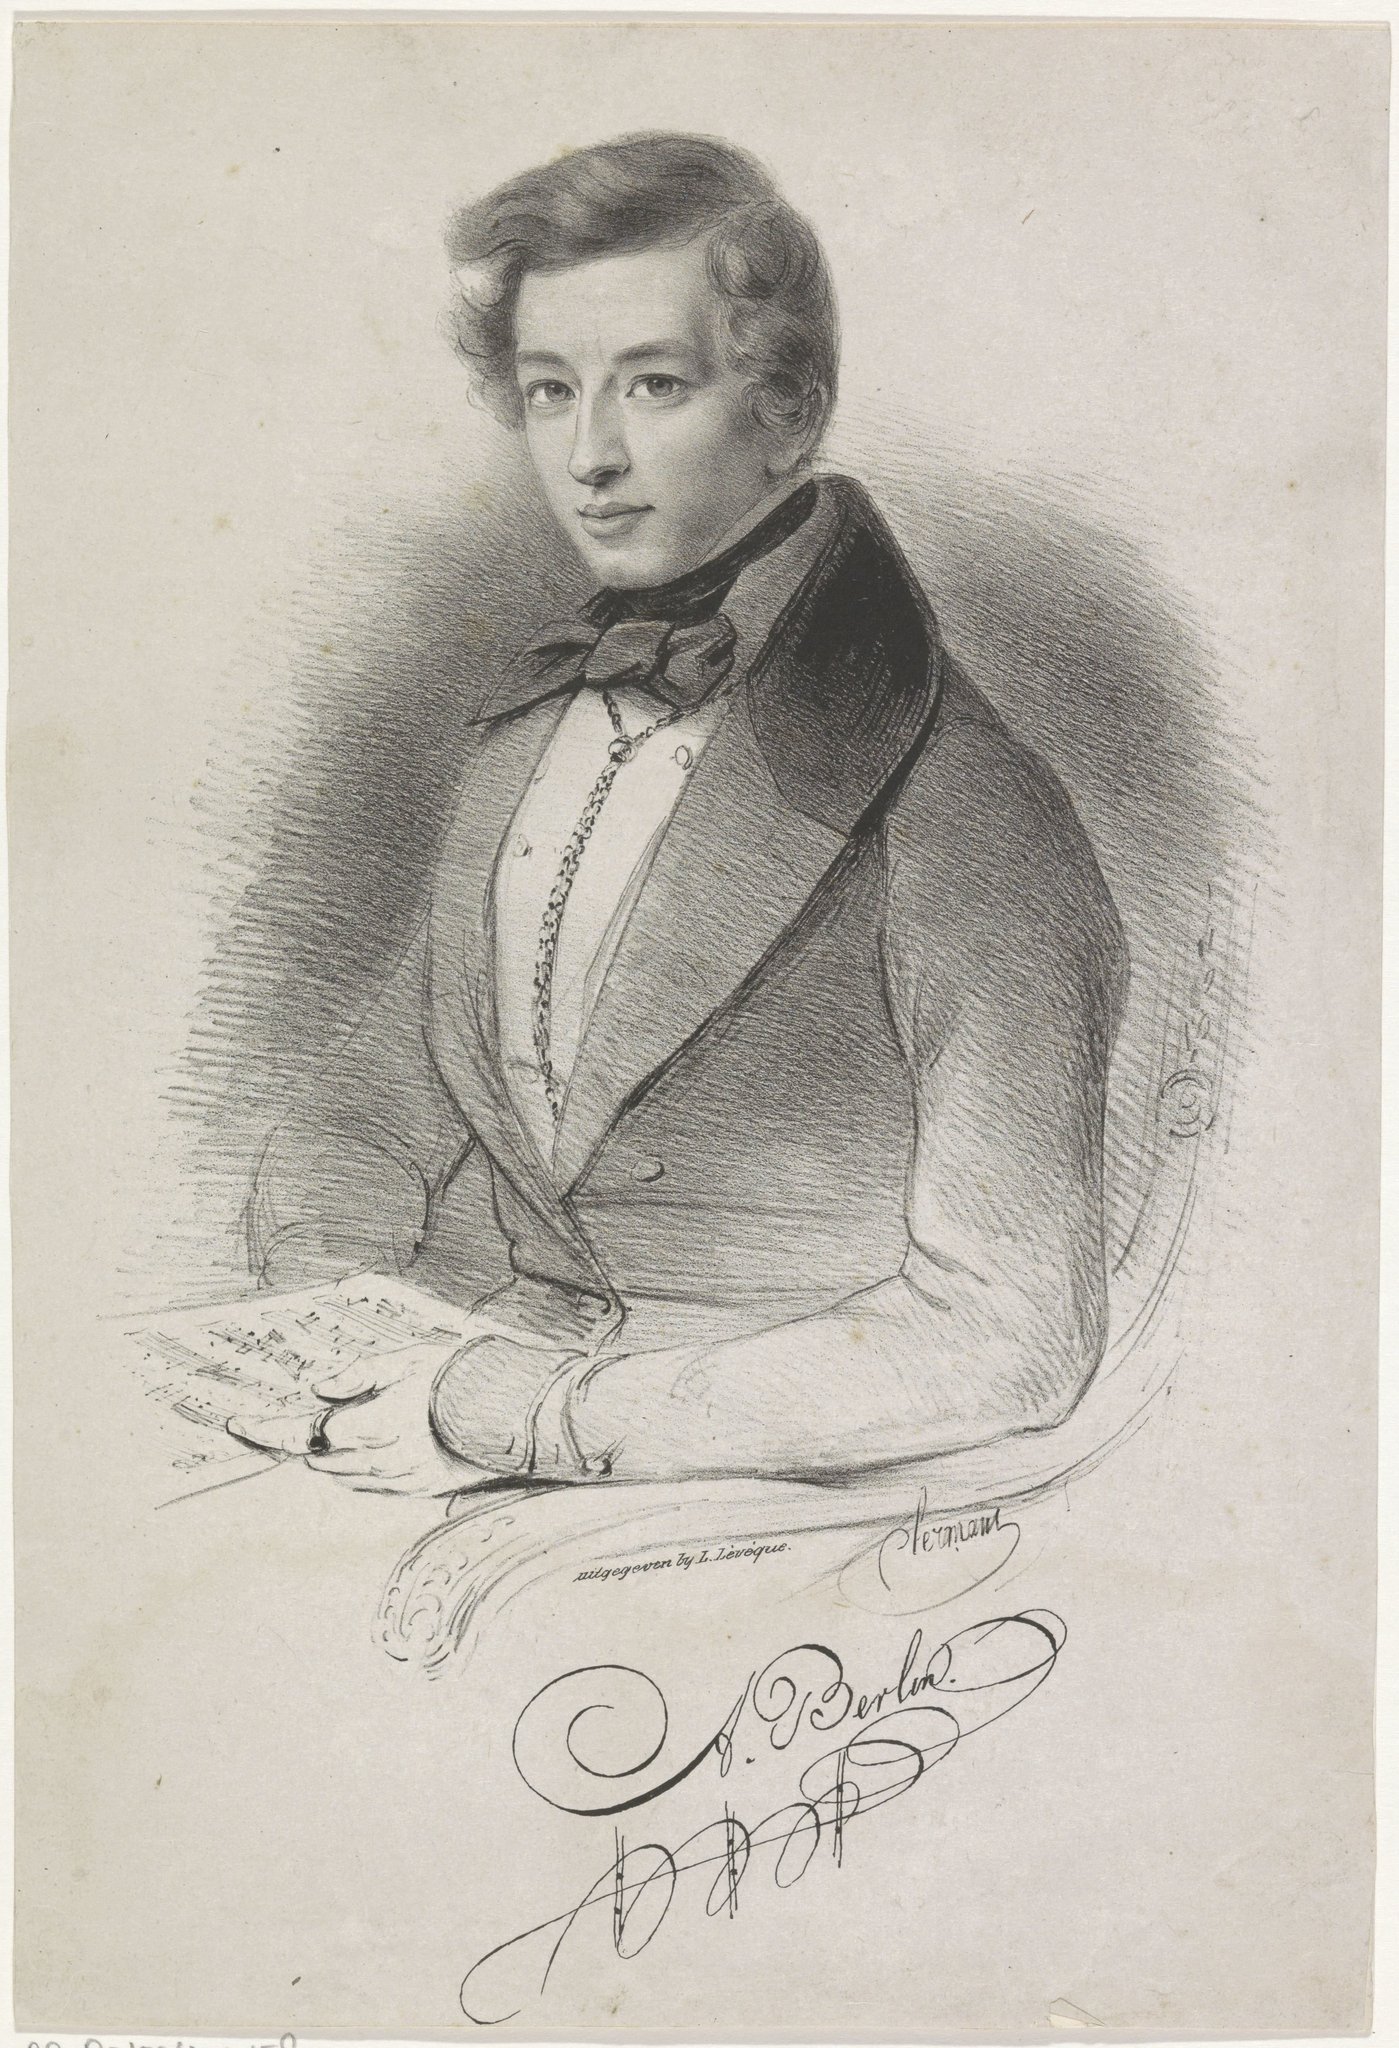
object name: print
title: Portret van A. W. Berlijn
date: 1826-1839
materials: paper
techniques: lithograph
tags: historical persons (+ half-length portrait), printed edition of musical score, watch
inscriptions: collector's mark: Lugt 2228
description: De geportretteerde zit op een stoel met een stuk bladmuziek in zijn schoot. Om zijn hals hangt een horlogeketting. Onder het portret zijn signatuur.